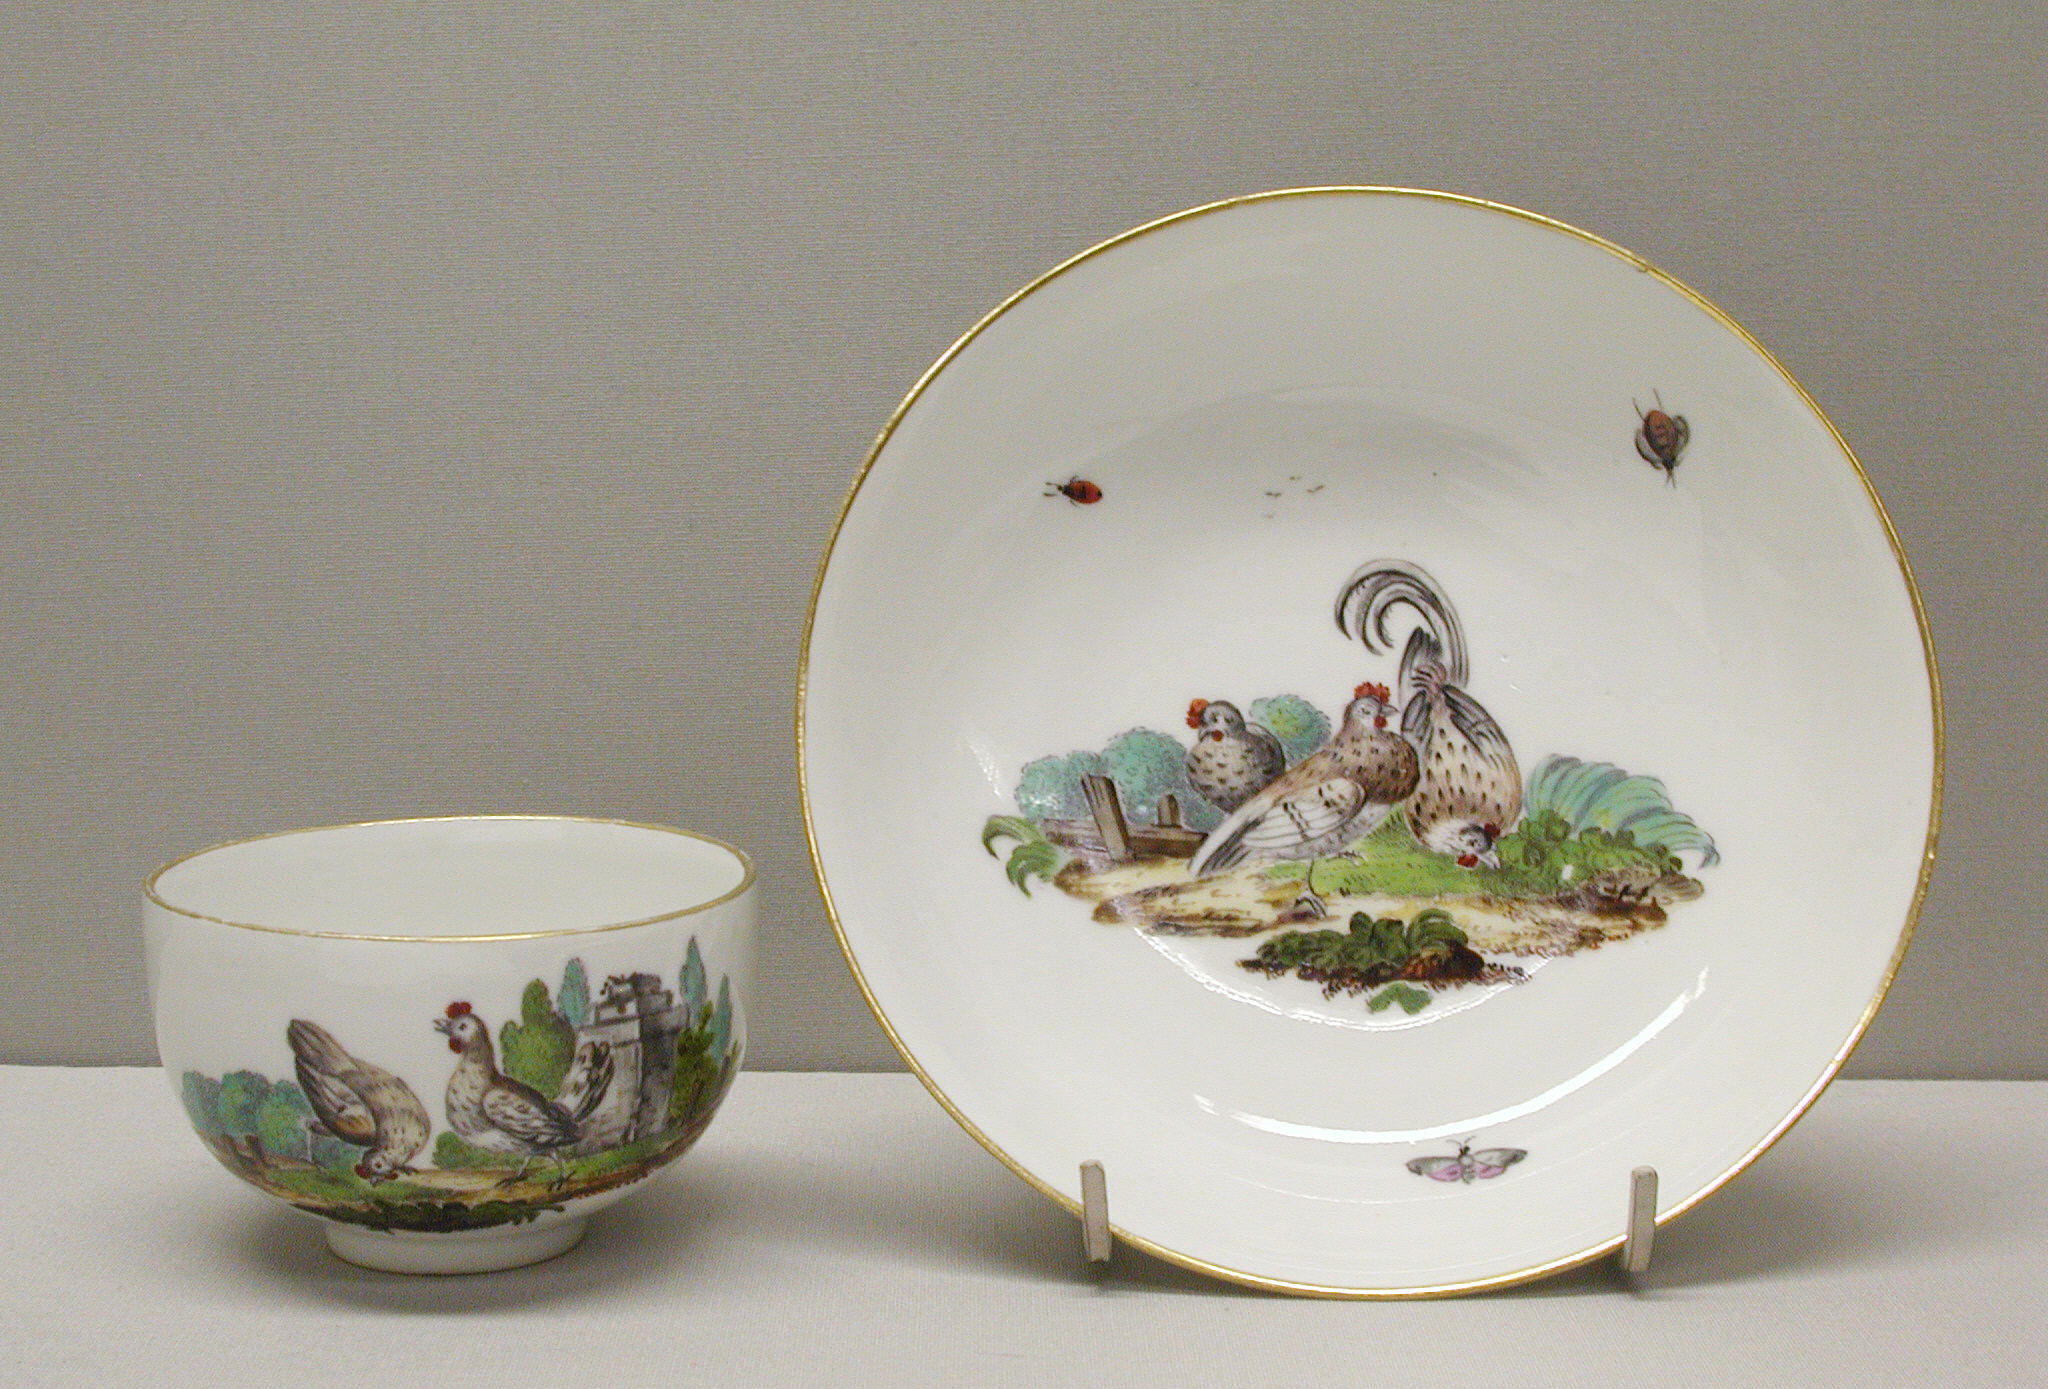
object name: teacup and saucer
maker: höchst manufactory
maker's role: manufactory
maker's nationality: german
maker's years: 1746-1796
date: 1775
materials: hard paste porcelain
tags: chickens,insects